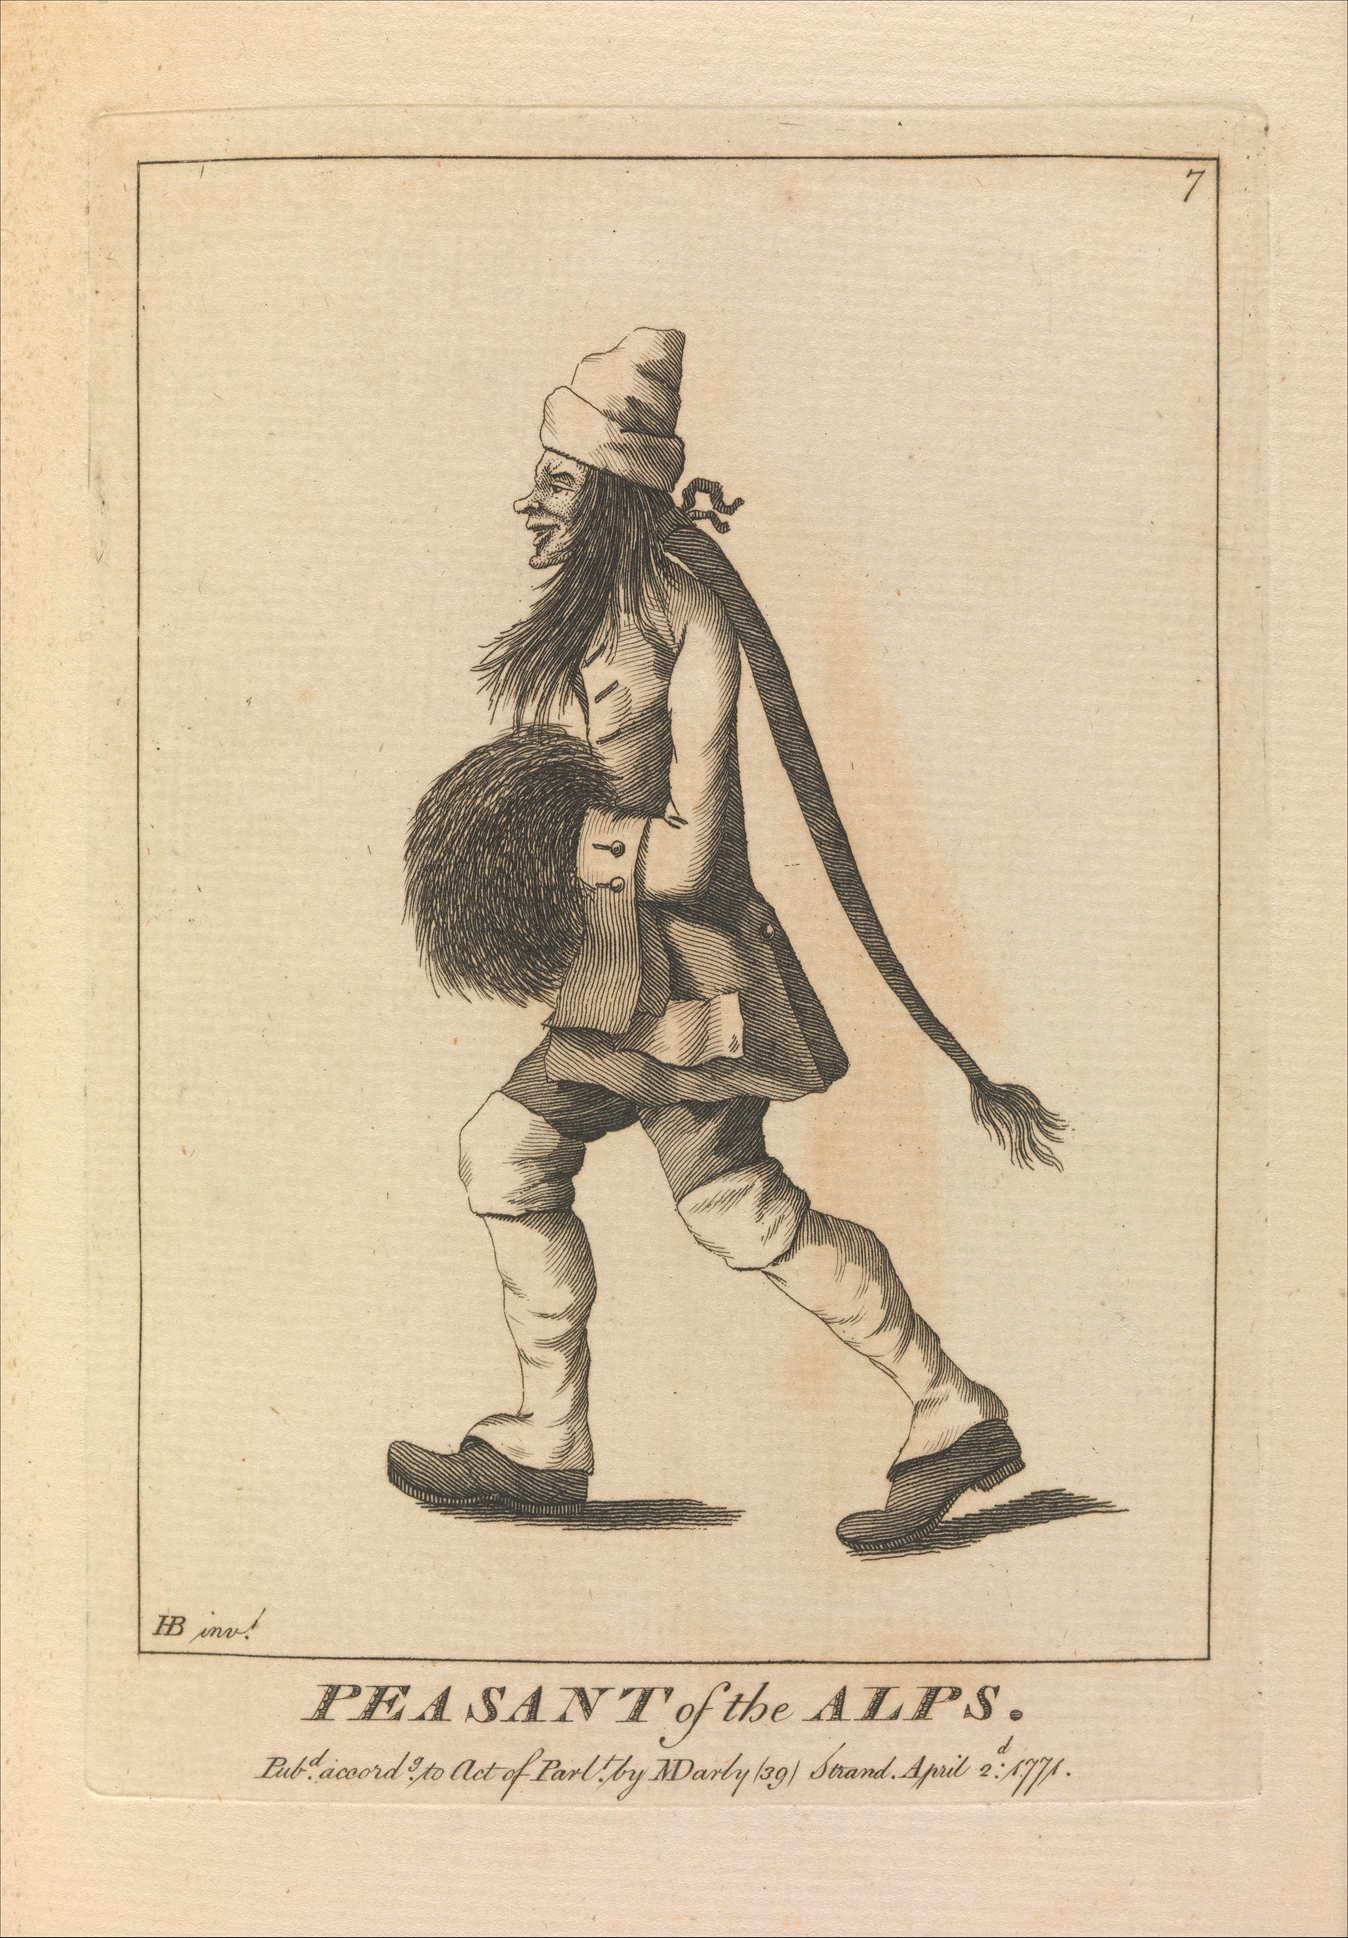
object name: print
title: Peasant of the Alps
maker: henry william bunbury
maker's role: artist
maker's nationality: british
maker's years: 1750-1811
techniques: etching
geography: london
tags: men,profiles